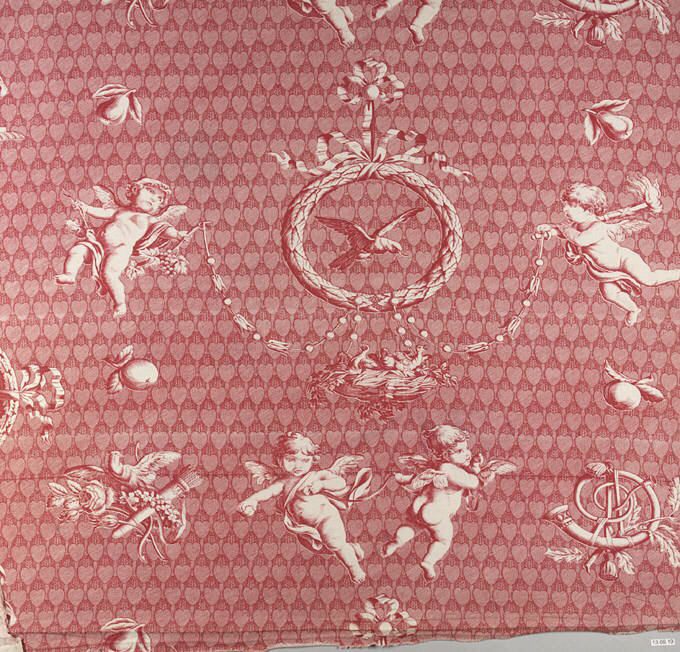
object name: fragment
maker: oberkampf manufactory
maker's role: manufactory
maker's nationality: french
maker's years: 1760-1843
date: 1810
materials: cotton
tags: musical instruments,birds,fruit